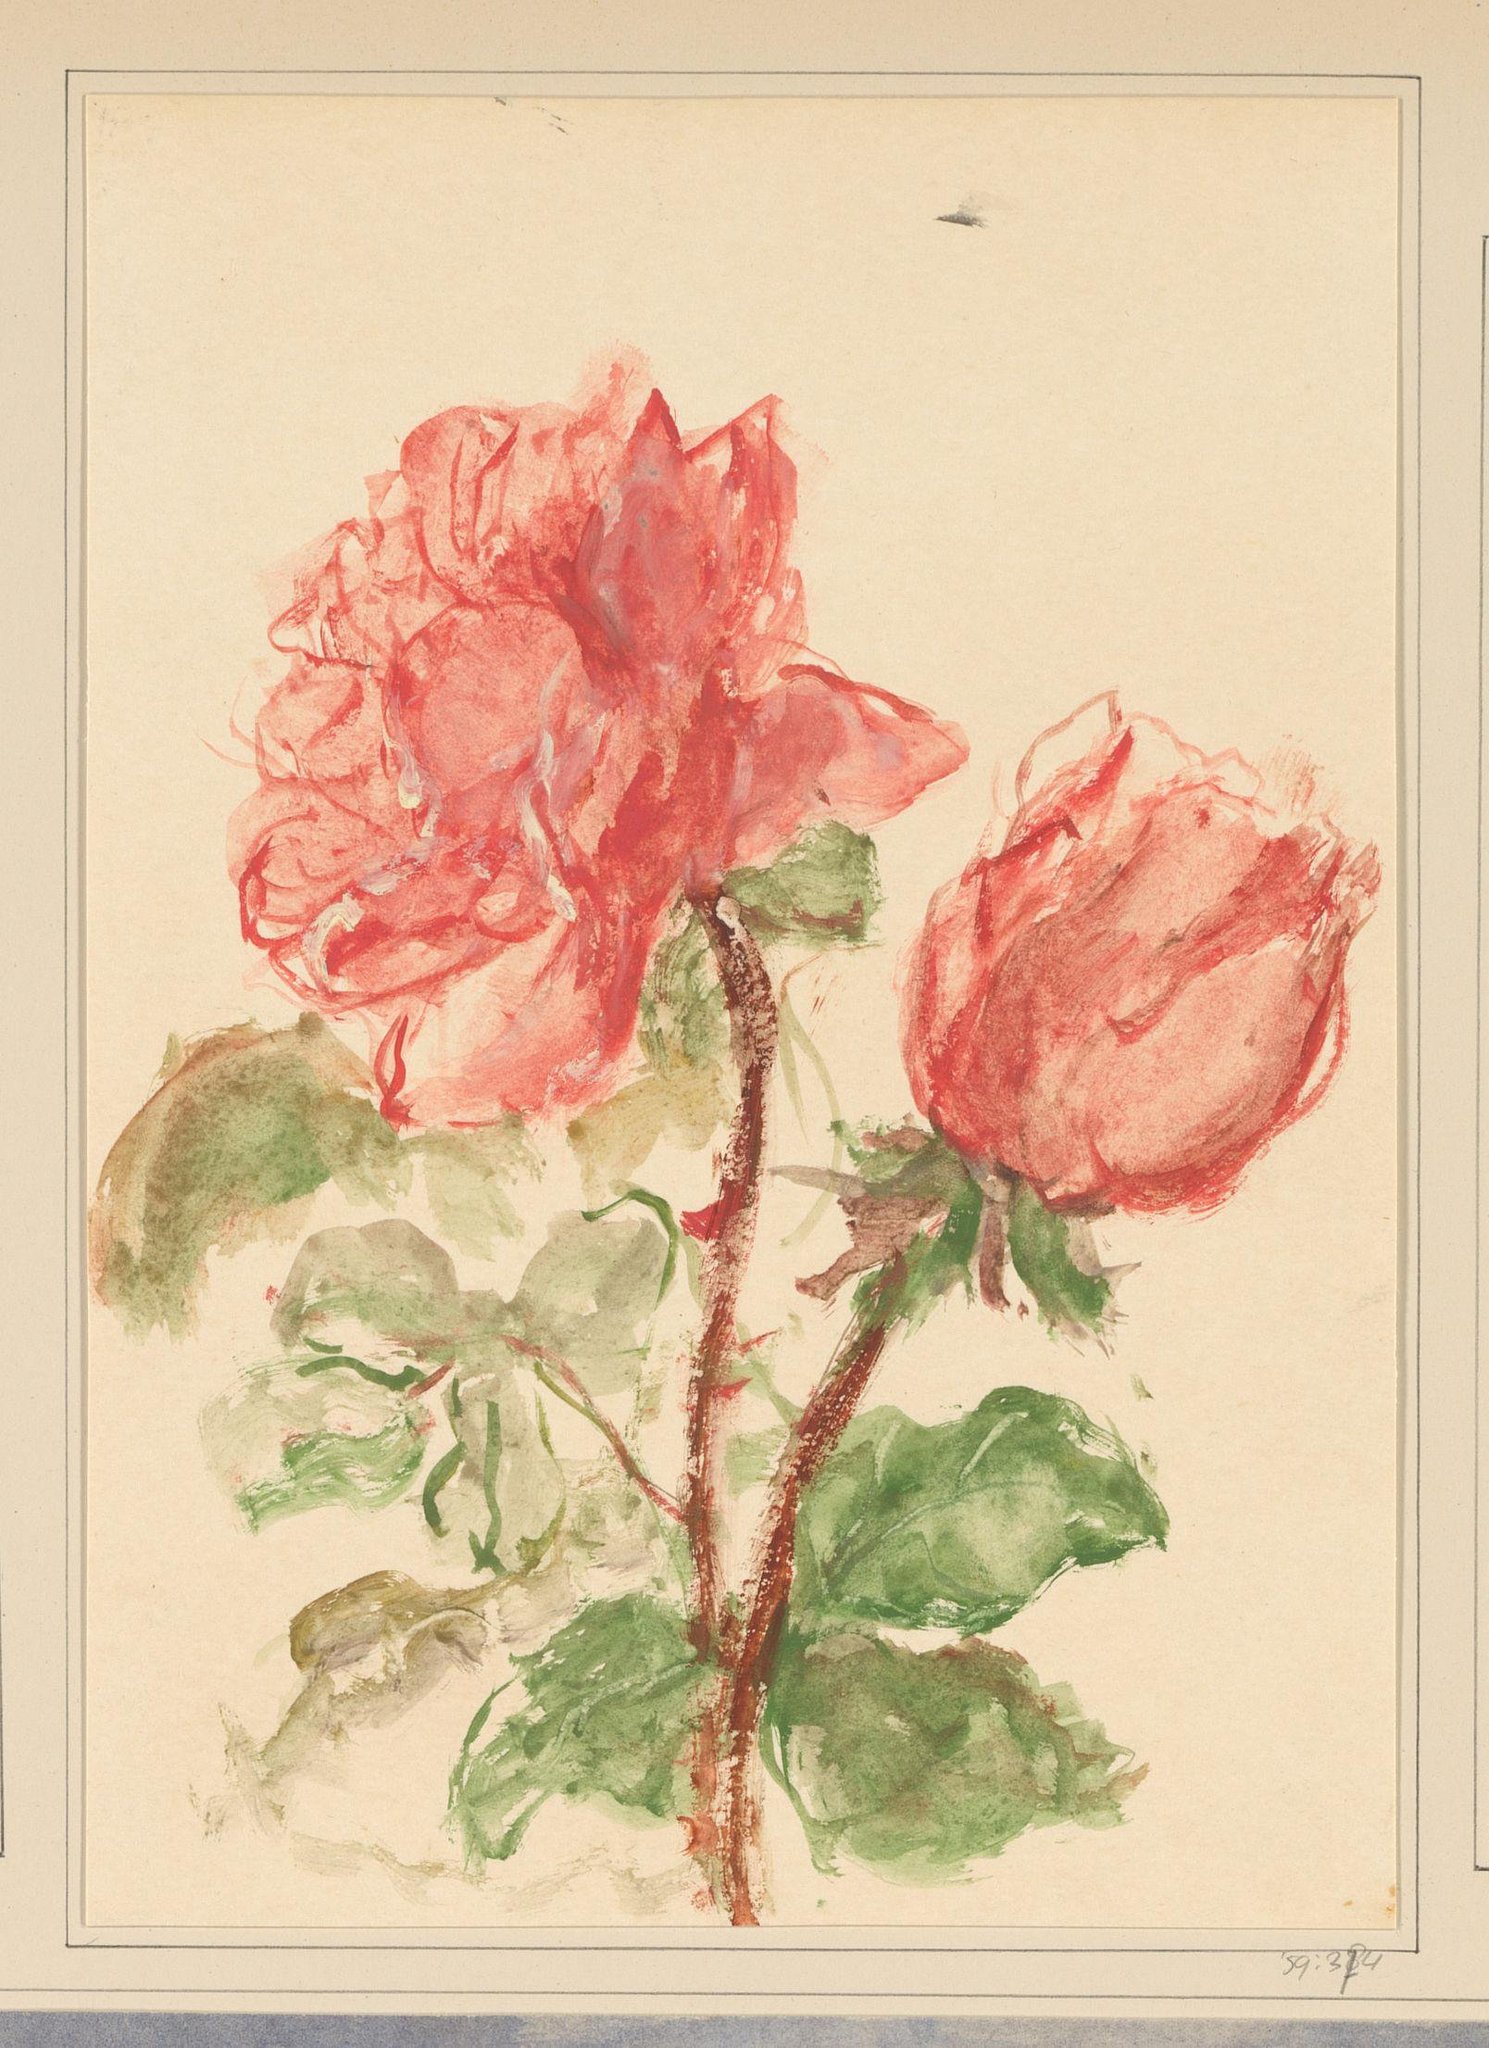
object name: drawing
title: Rozen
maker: sientje mesdag-van houten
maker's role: draughtsman, painter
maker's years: 1834-1909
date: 1856-1909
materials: paper, watercolor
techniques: brush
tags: flowers: rose